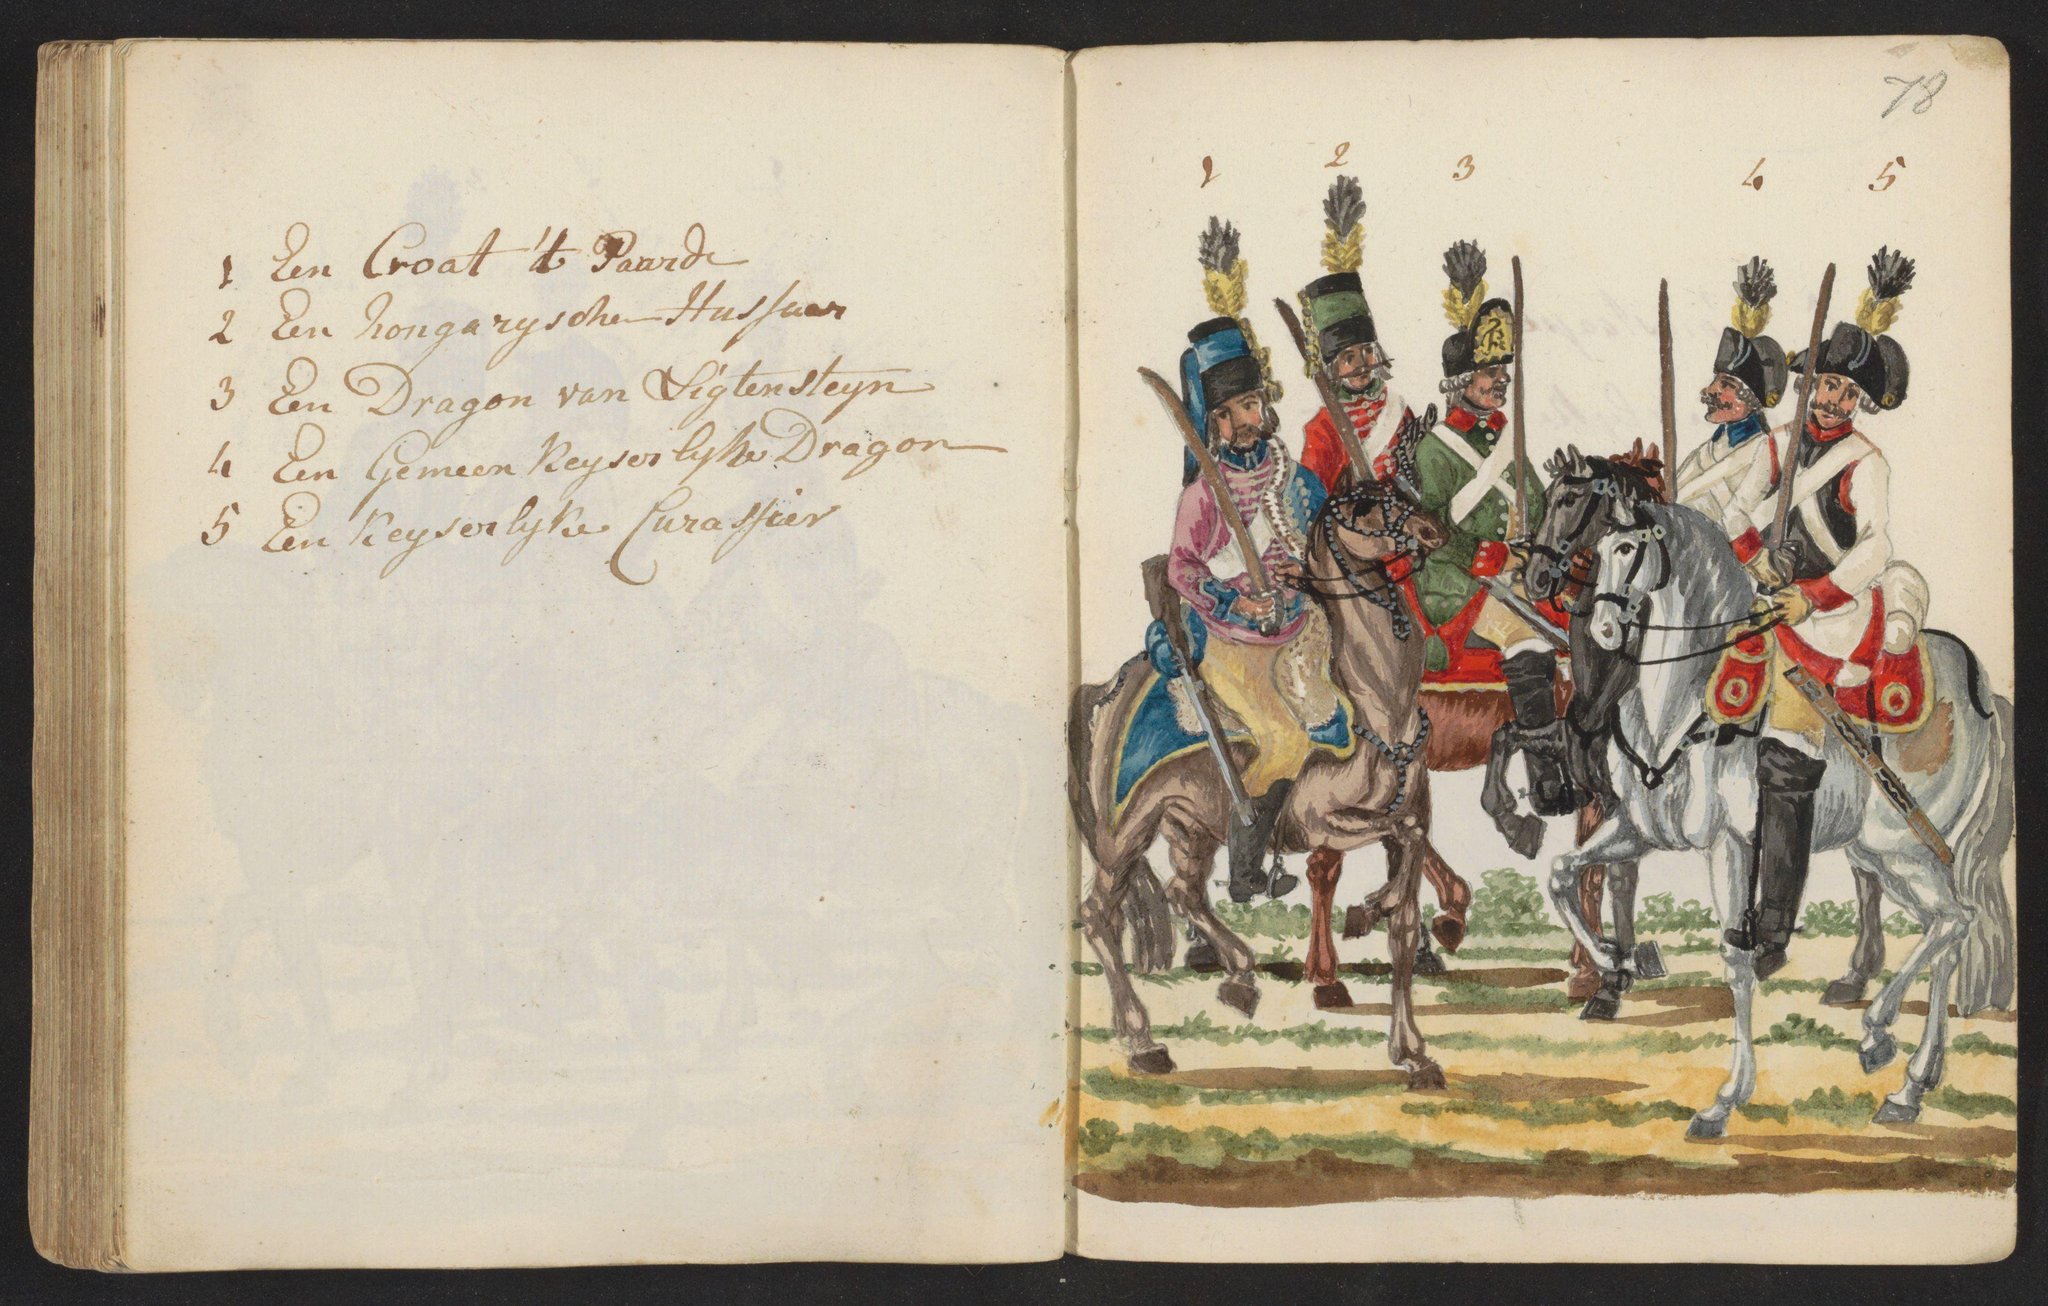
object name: drawing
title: Uniformen van buitenlandse cavalerie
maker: s.g. casten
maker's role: draughtsman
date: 1795-1796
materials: paper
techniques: writing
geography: amsterdam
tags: (military) uniforms (+ infantry), patriots (1780-1795)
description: De uniformen van vijf verschillende officieren van de cavalerie. Kroaat, Hongaarse huzaar, dragonder van Liechtenstein, en een Oostenrijkse keizerlijke dragonder en kurassier, allen te paard, ca. 1788-1795. Onderdeel van het derde hoofdstuk over de nieuwe uniformen in de periode na het herstel van de prins van Oranje en de komst van de Pruisische troepen in Holland in 1787. In het schetsboek met gekleurde tekeningen van de uniformen van militairen en leden van de schutterij uit de periode 1770 tot 1795-1796.